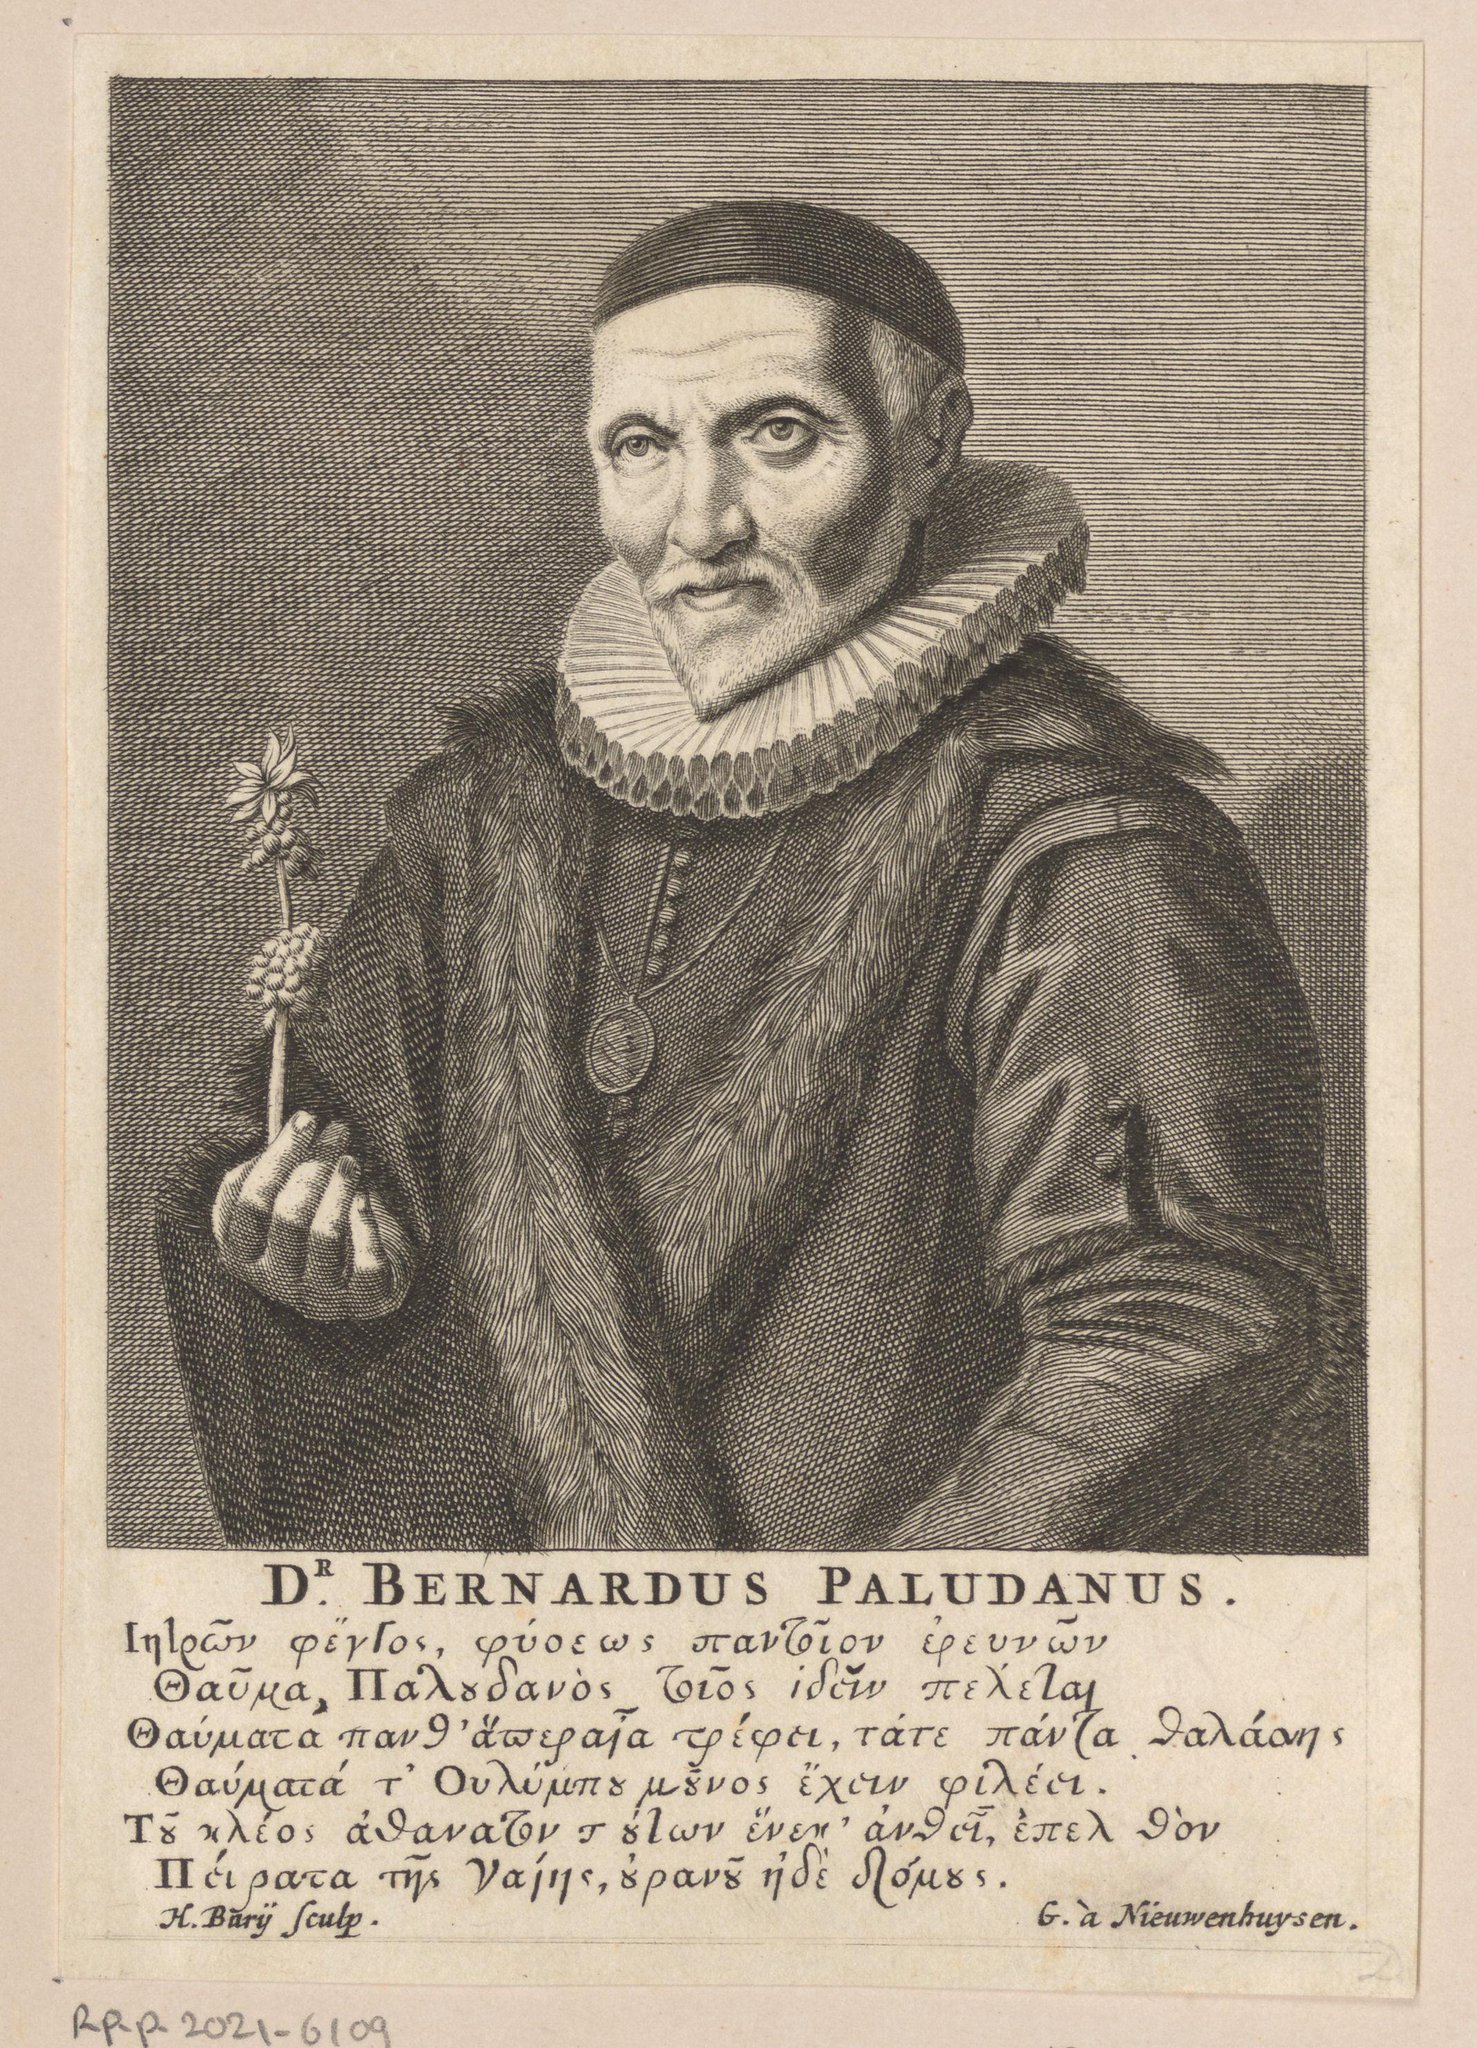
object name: print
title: Portret van Bernardus Paludanus op 80-jarige leeftijd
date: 1666-1747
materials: paper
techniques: engraving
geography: netherlands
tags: enkhuizen, adult man, historical persons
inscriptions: collector's mark: Lugt 240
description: Prent uit: Brandt, Geeraert. Historie der vermaerde zee- en koop-stadt Enkhuisen (...). Enkhuizen: Egbert van den Hoof, 1666. Of uit de tweede druk (Enkhuizen: Jacob Duyn, 1747).